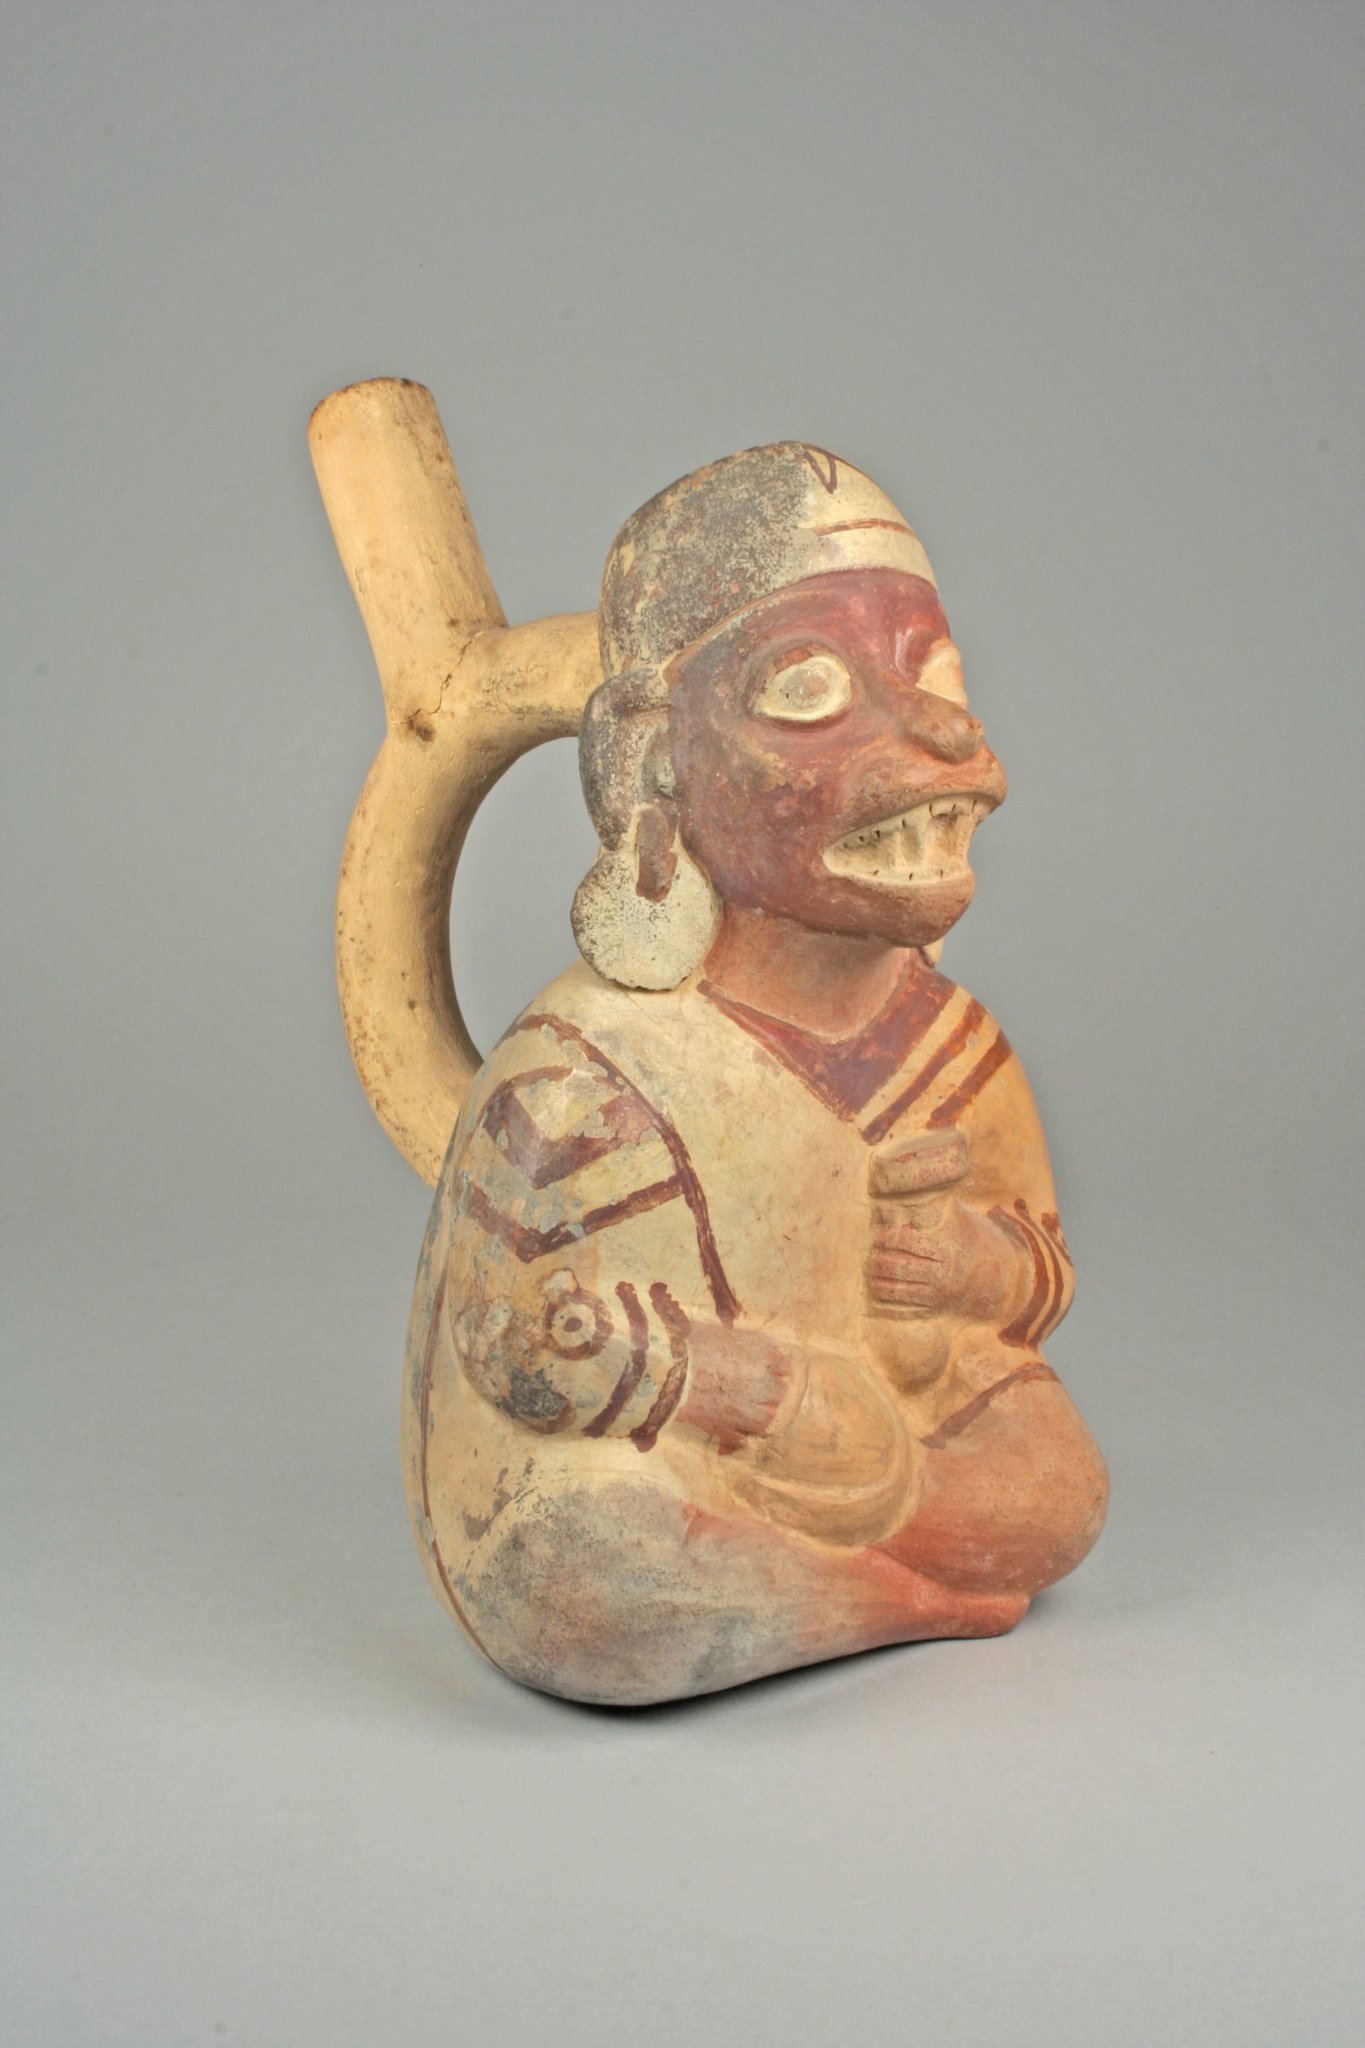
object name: bottle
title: Anthropomorphized Monkey Bottle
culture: moche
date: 301-700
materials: ceramic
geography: peru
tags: monkeys